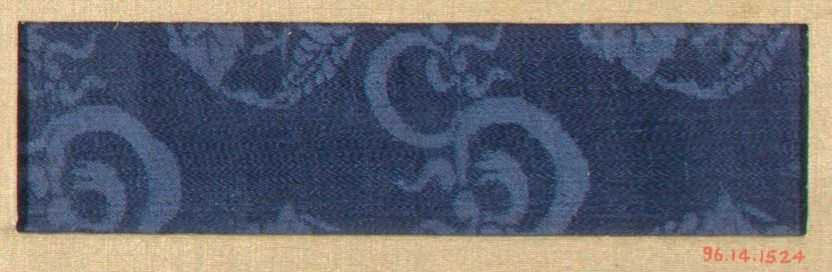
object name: piece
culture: japanese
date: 1701-1900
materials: silk